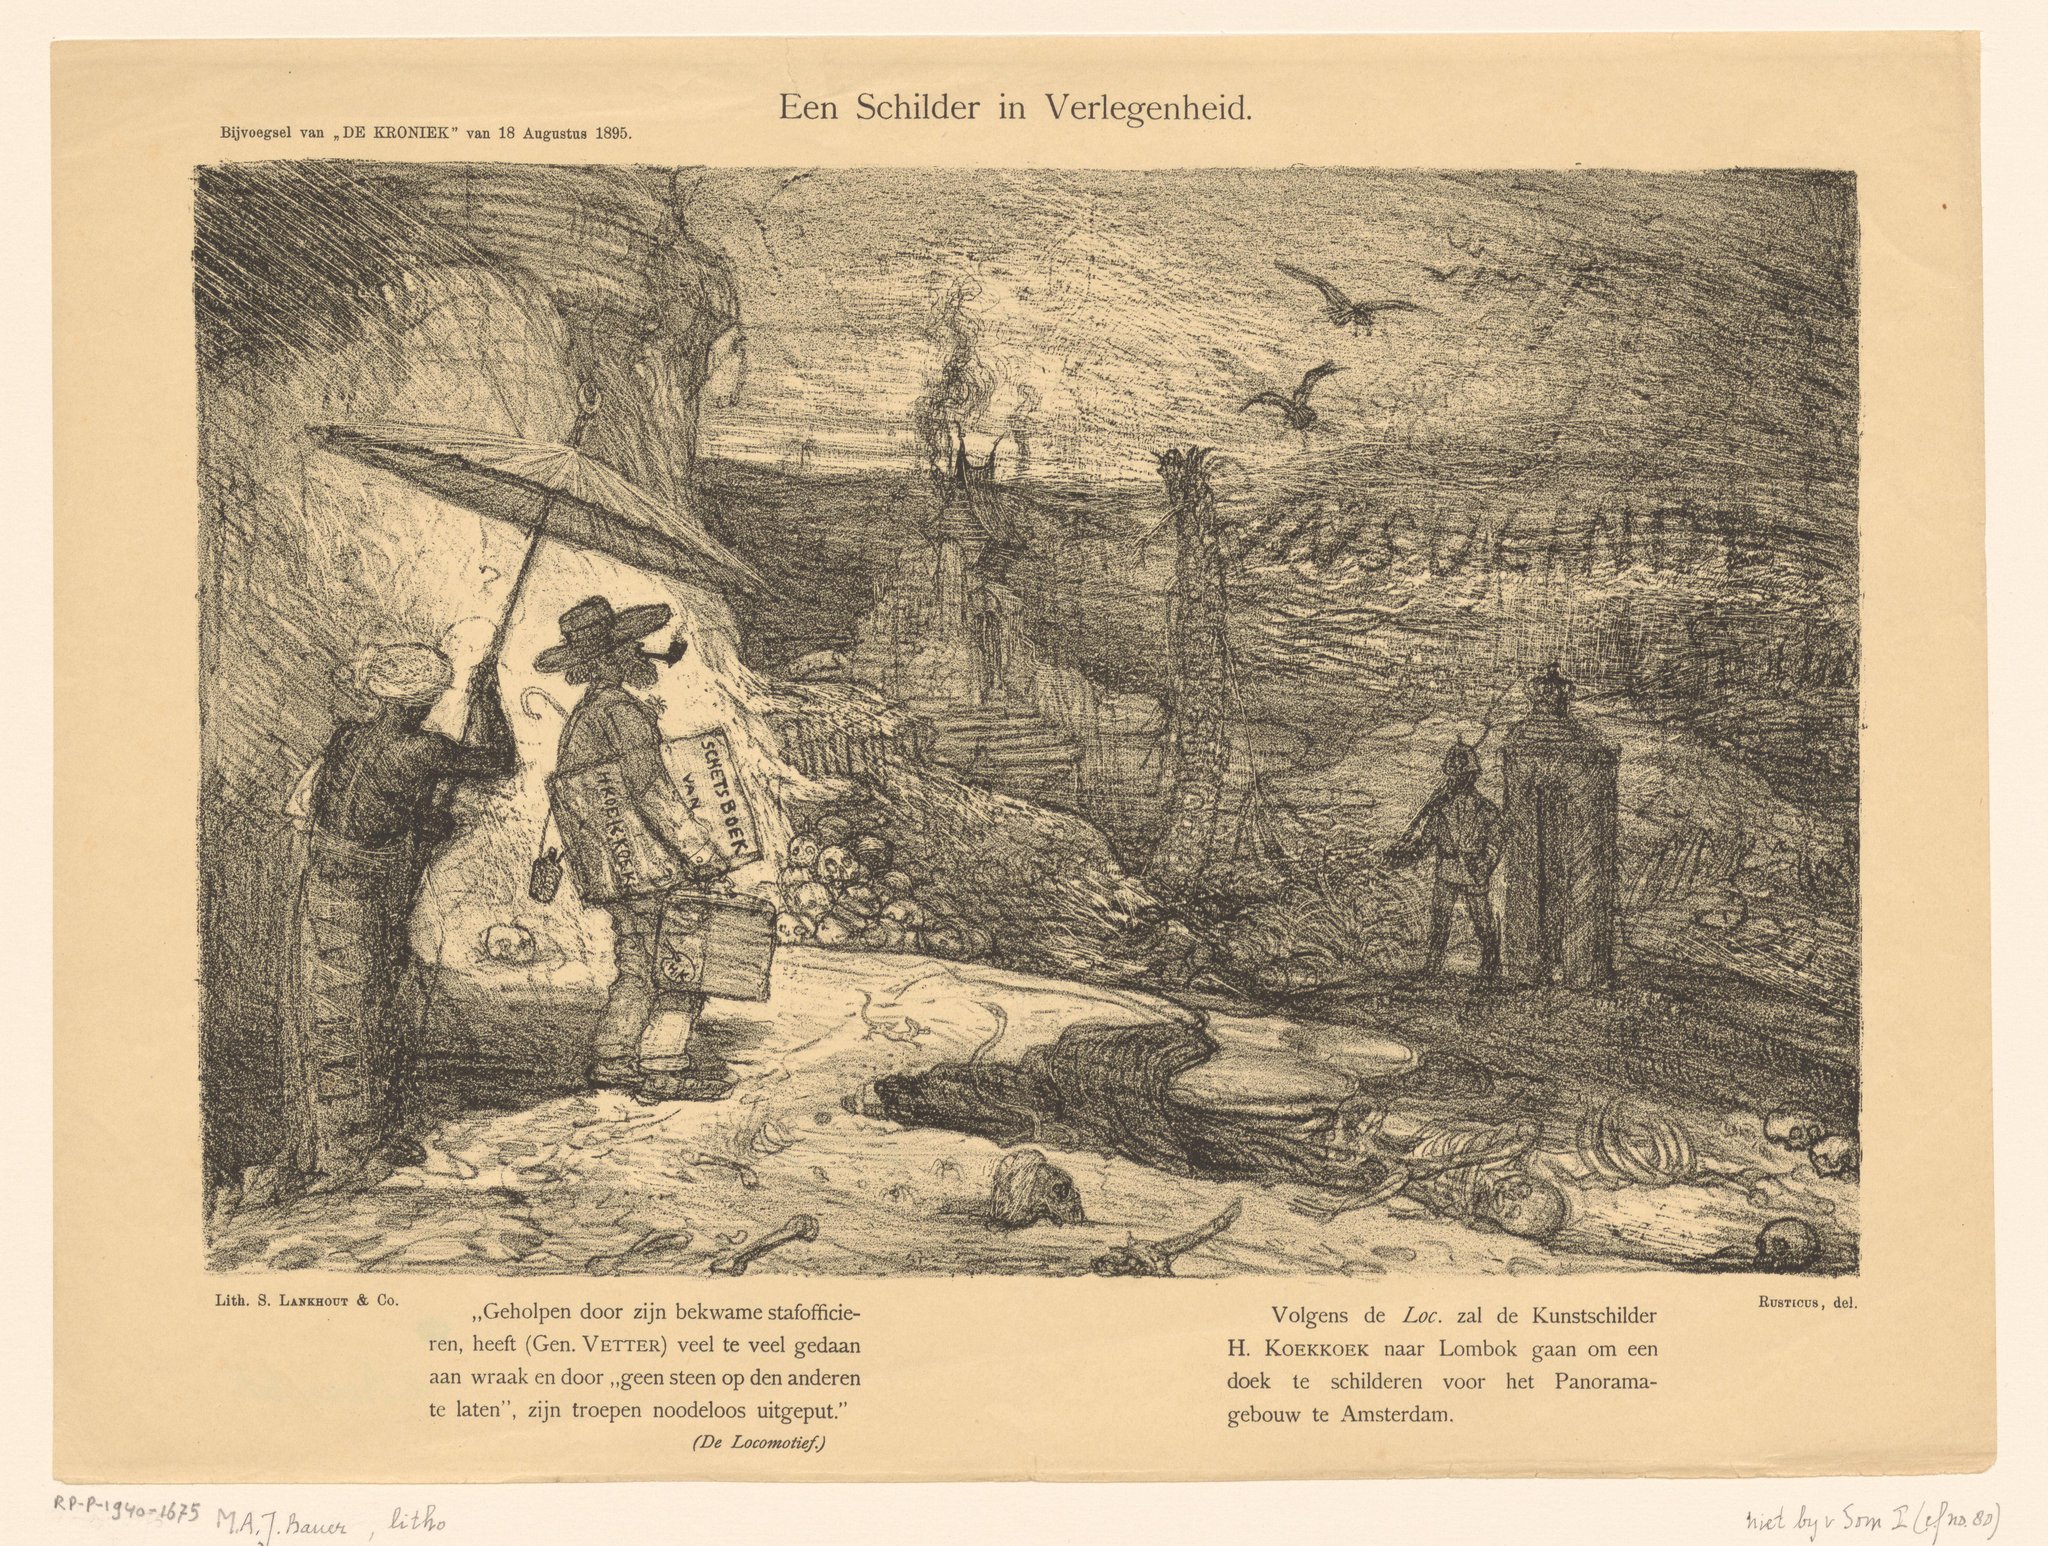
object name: print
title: Een schilder in verlegenheid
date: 1895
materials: paper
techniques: lithograph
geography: the hague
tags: draughtsman, hermanus koekkoek (i), the hague, landscapes, historical persons, painter at work, in his studio - cc - out of doors, political caricatures and satires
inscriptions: collector's mark: Lugt 2760, collector's mark: Lugt 2166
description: De schilder Hermanus Koekkoek met zijn schetsboek gearriveerd bij de grens van het verwoeste 'Insulinde', hier verwijzend naar Lombok. Achter hem houdt een Lombokse man een parasol boven zijn hoofd. Kaal landschap bezaaid met skeletten en rokende puinhopen, aasgieren in de lucht, bewaakt door een soldaat staande bij zijn wachthuisje. Aanklacht tegen het bloedig optreden van Vetter bij het neerslaan van de opstand op Lombok in 1894. Onderaan twee teksten van vier regels.